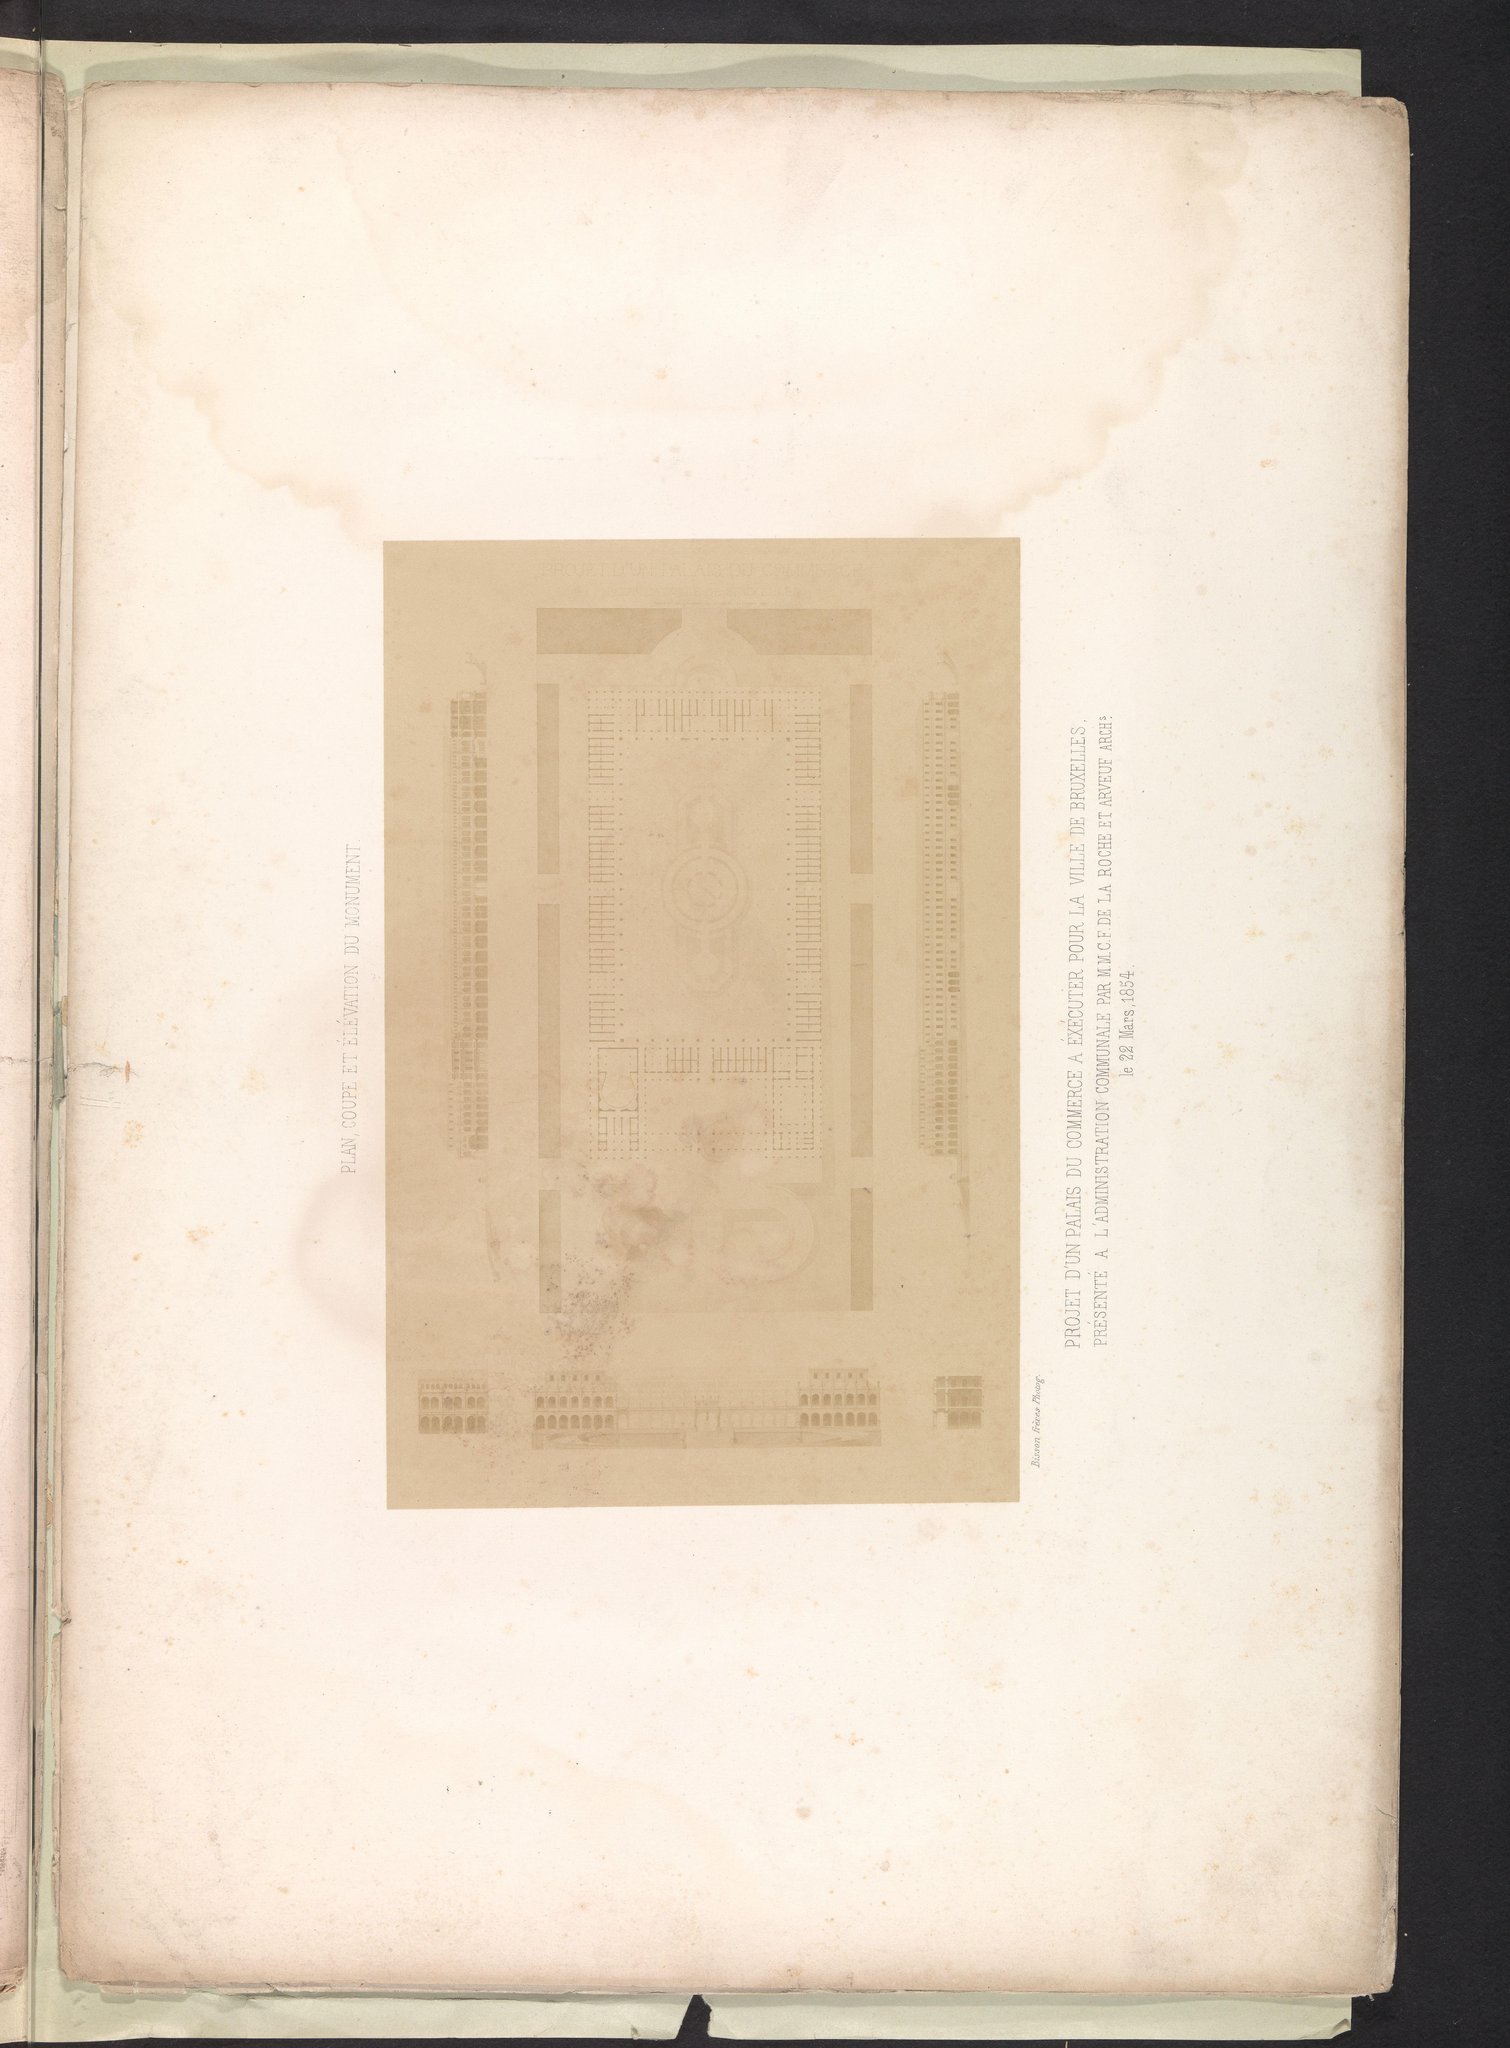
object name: photograph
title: Fotoreproductie van een tekening, voorstellende een plattegrond van een handelsgebouw te Brussel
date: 1853-1854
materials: photographic support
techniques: albumen print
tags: maps of cities